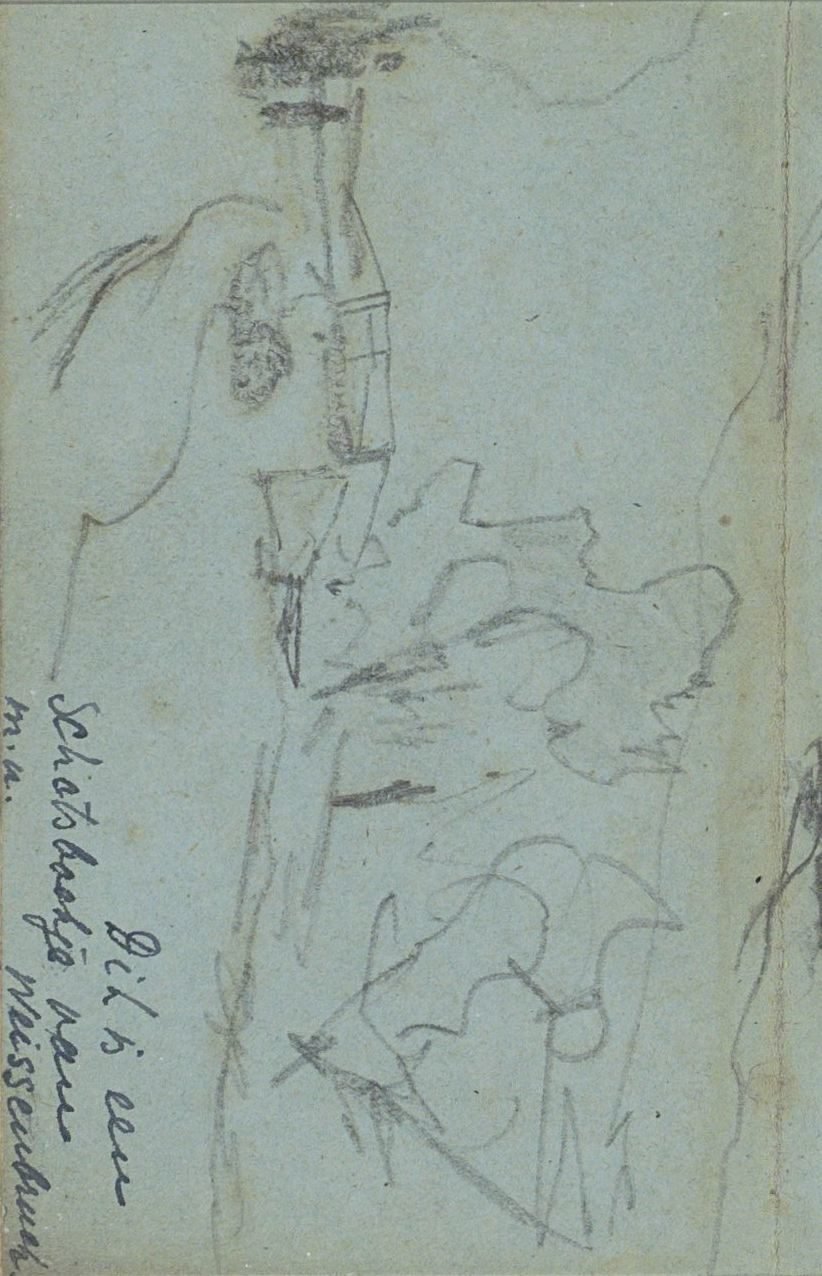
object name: sketchbook leaf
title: Landschap met een brug over een rivier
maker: johan hendrik weissenbruch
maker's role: draughtsman, painter, print maker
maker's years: 1824-1903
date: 1834-1903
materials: paper, pencil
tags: landscapes with waters, waterscapes, seascapes (in the temperate zone), bridge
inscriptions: annotation: ‘Dit is een/ schetsboekje van/ m.u. Weissenbruch.’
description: Verso-zijde van het achterste schutblad uit een schetsboek met 32 bladen.